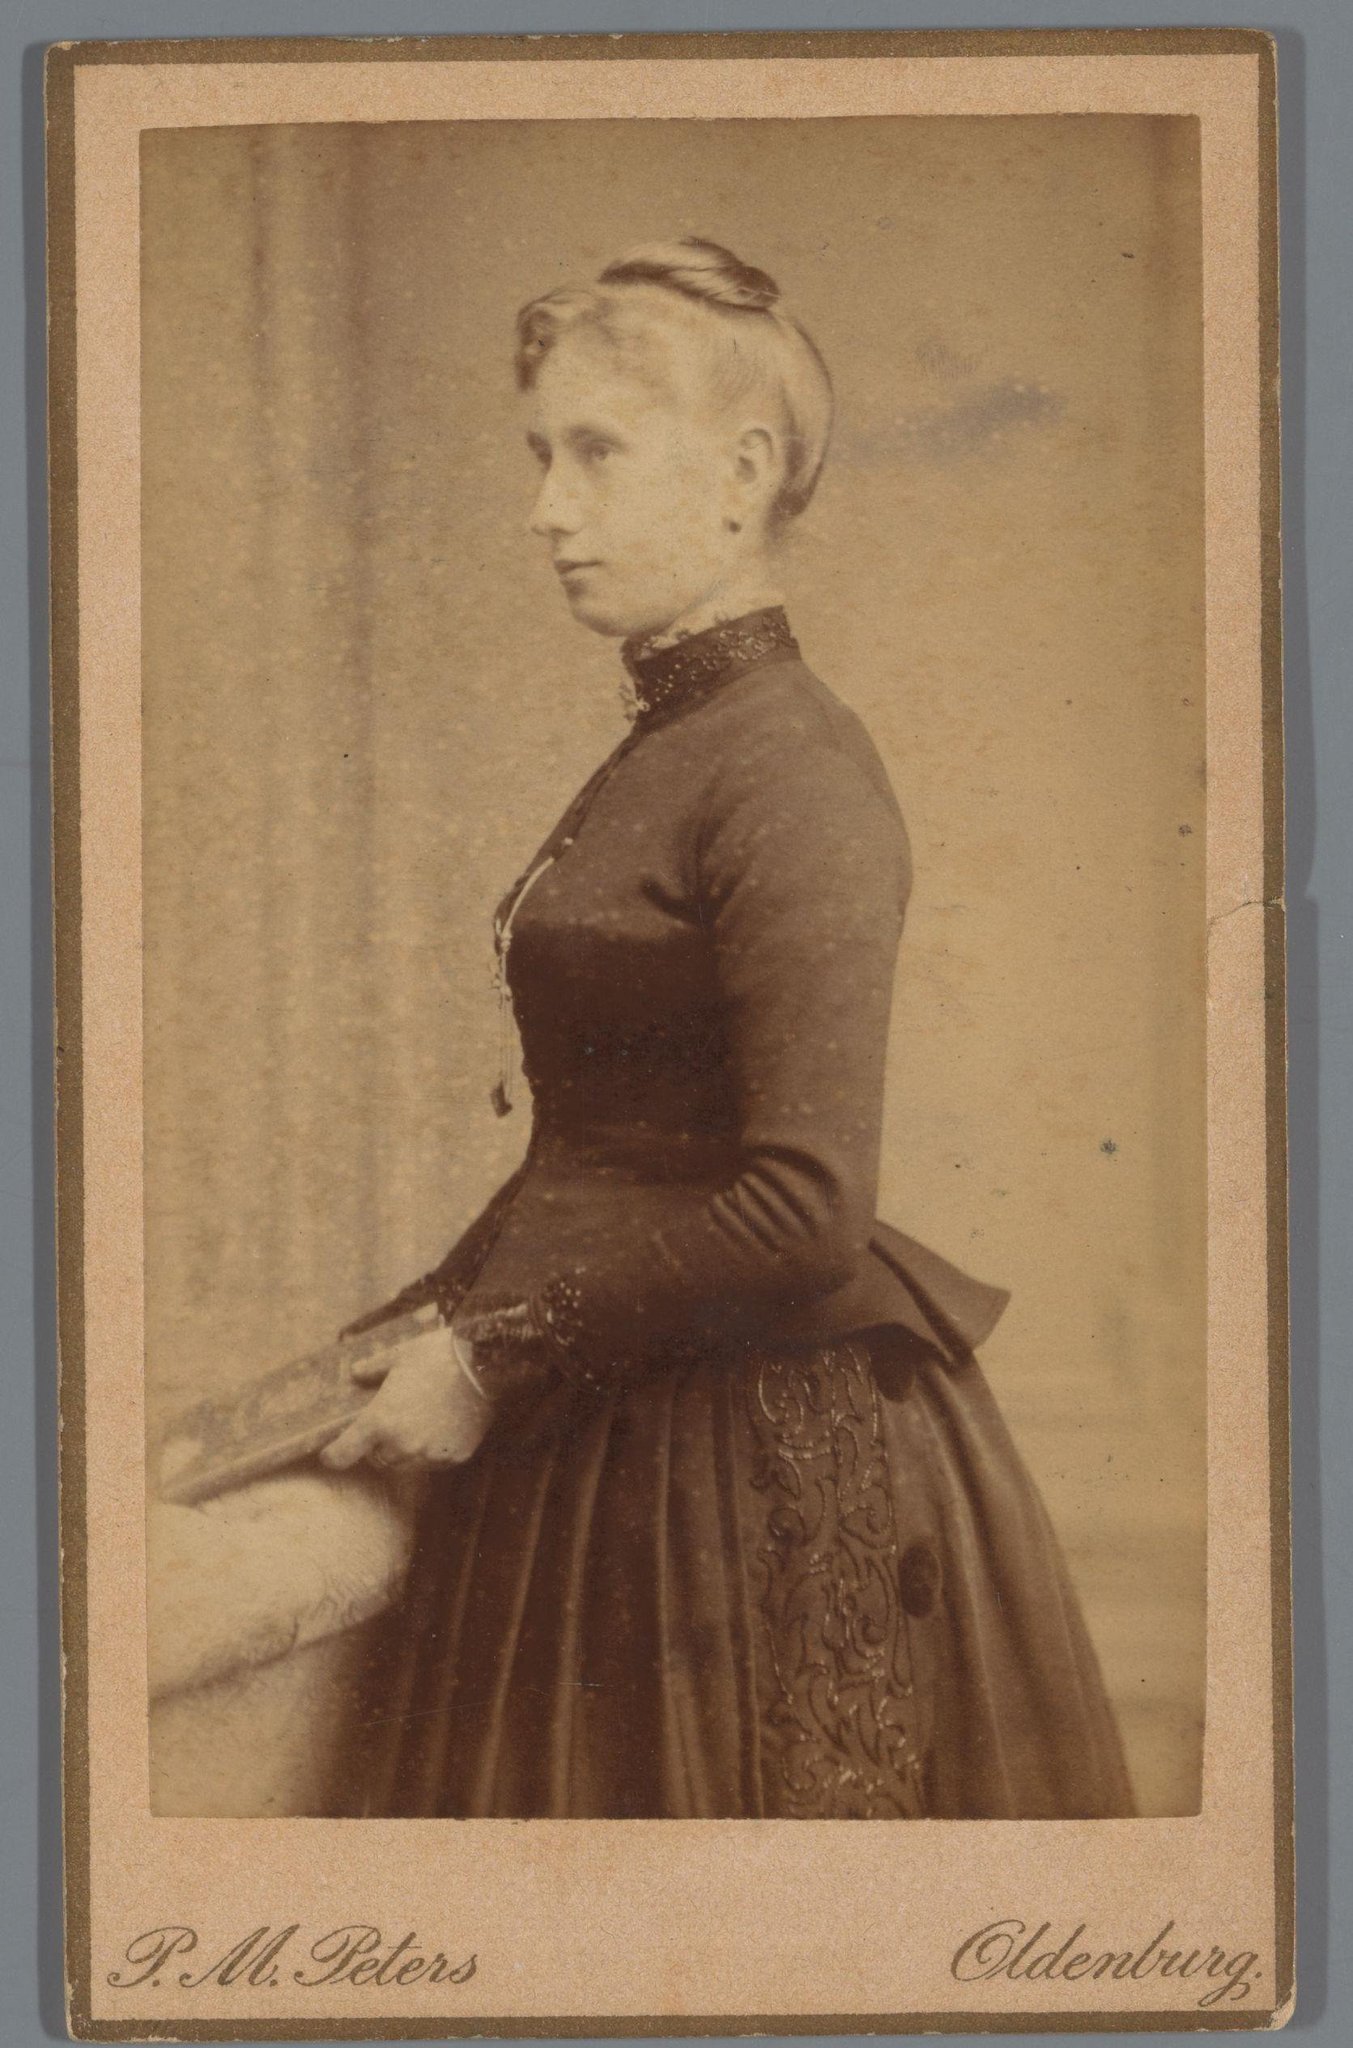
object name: photograph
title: Portret van Gertruda Melcher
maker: p.m. peters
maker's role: fotograaf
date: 1887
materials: cardboard, paper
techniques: albumen print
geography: oldenburg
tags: adolescent, young woman, maiden, historical persons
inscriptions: monogram: ‘PMP’, inscription: ‘P.M. Peters Oldenburg.’, inscription: ‘Gertruda Melcher/ Vegtha/ dochter v/d broer vader/ L. Nopper/ echtgenote Janssen’, inscription: ‘P.M. Peters/ Photogr. Atelier./ Oldenburg/ Innerer Damm No. 12,/ gegenüber dem Schlosse./ Die Platte bleibt für Nachbestellungen aufbewahrt.’